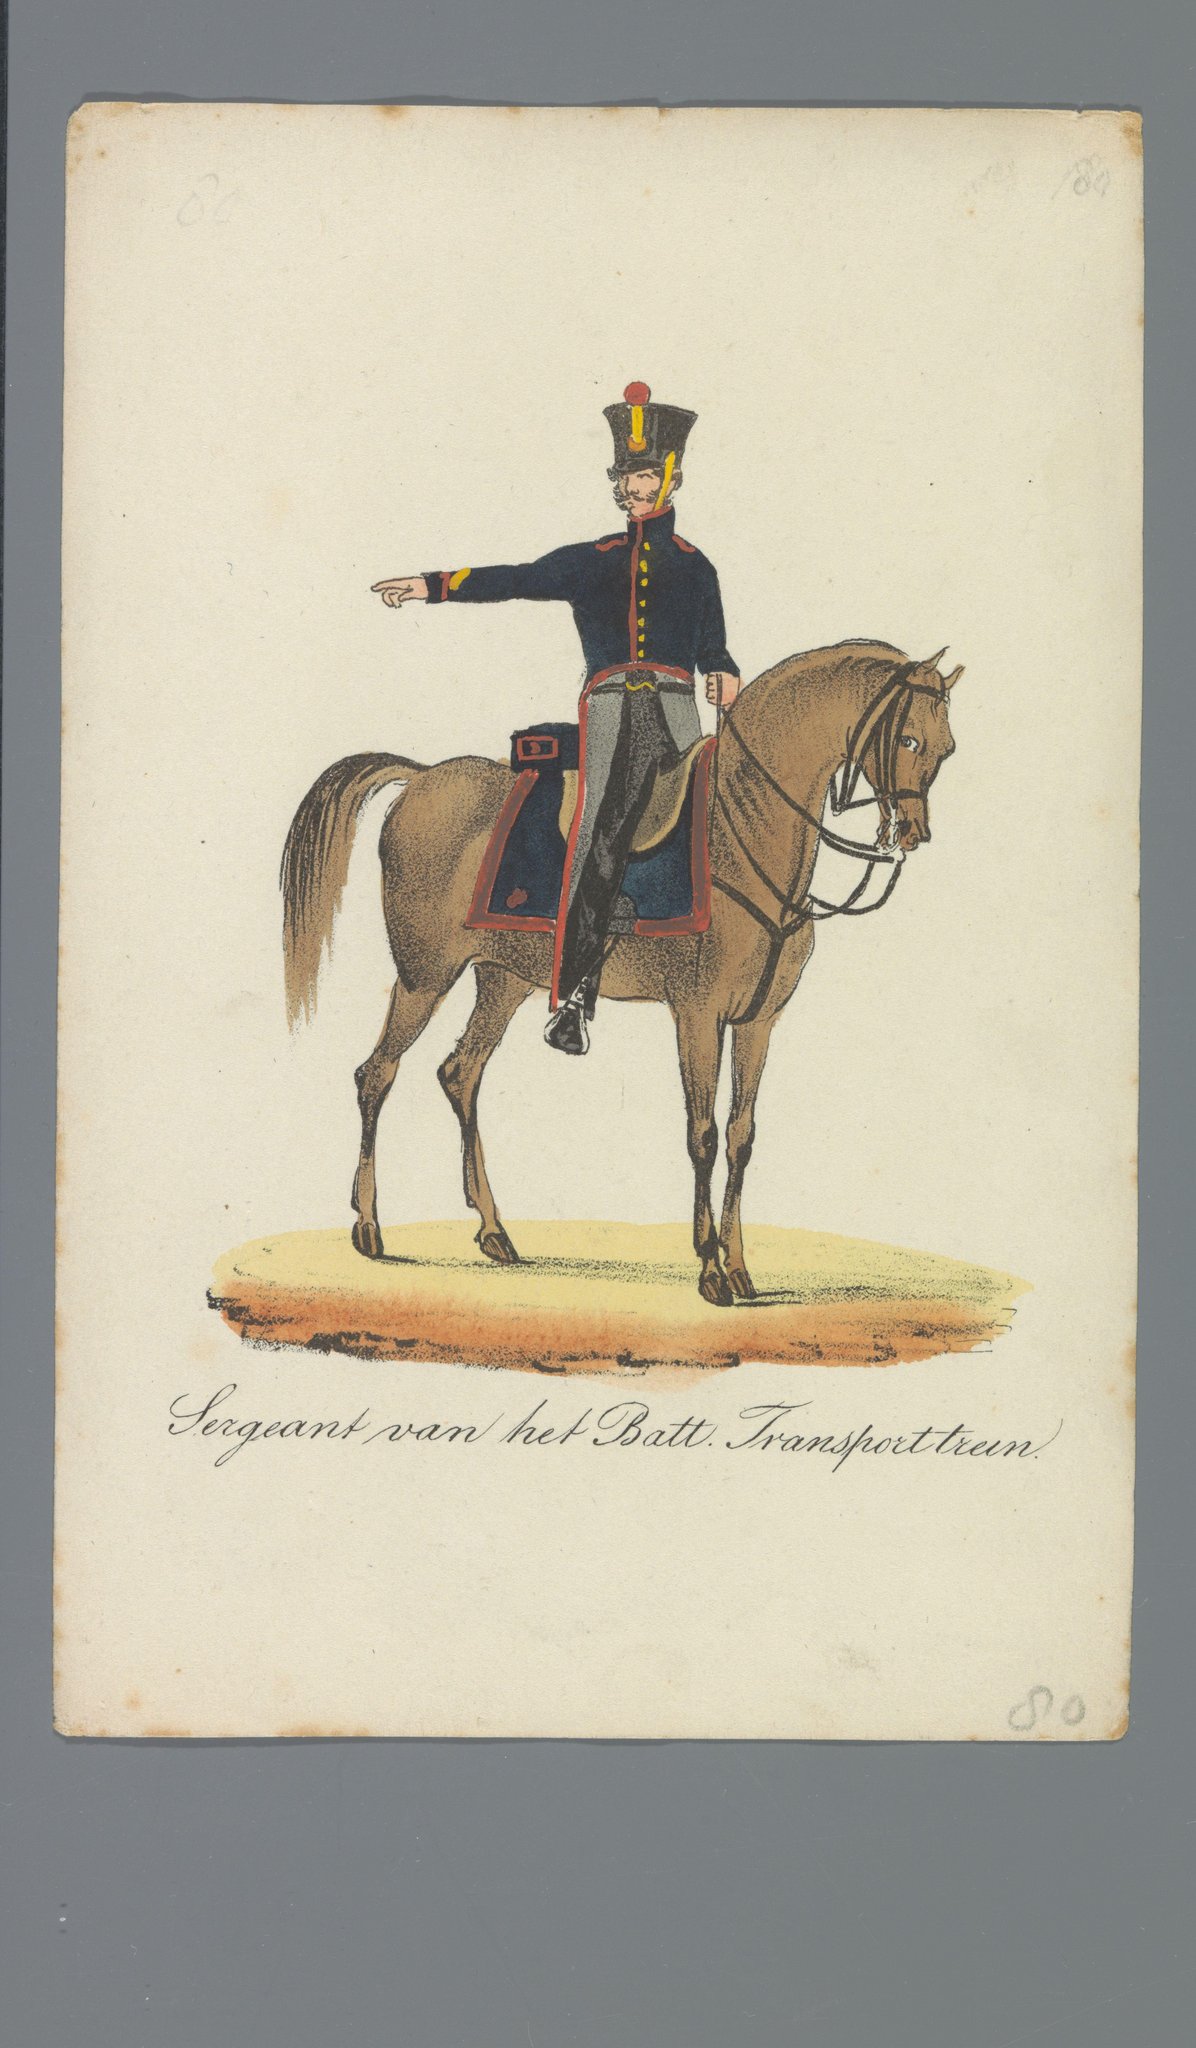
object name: print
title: Sergeant van het Batt. Transporttrein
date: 1835-1850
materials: paper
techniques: hand coloring, lithograph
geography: netherlands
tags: (military) uniforms, clothes, costume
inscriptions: collector's mark: Lugt 2228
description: Sergeant van de artillerietransporttrein, te paard. Onderdeel van een serie van 157 losse bladen met Nederlandse militaire uniformen in de jaren 1830-1832.